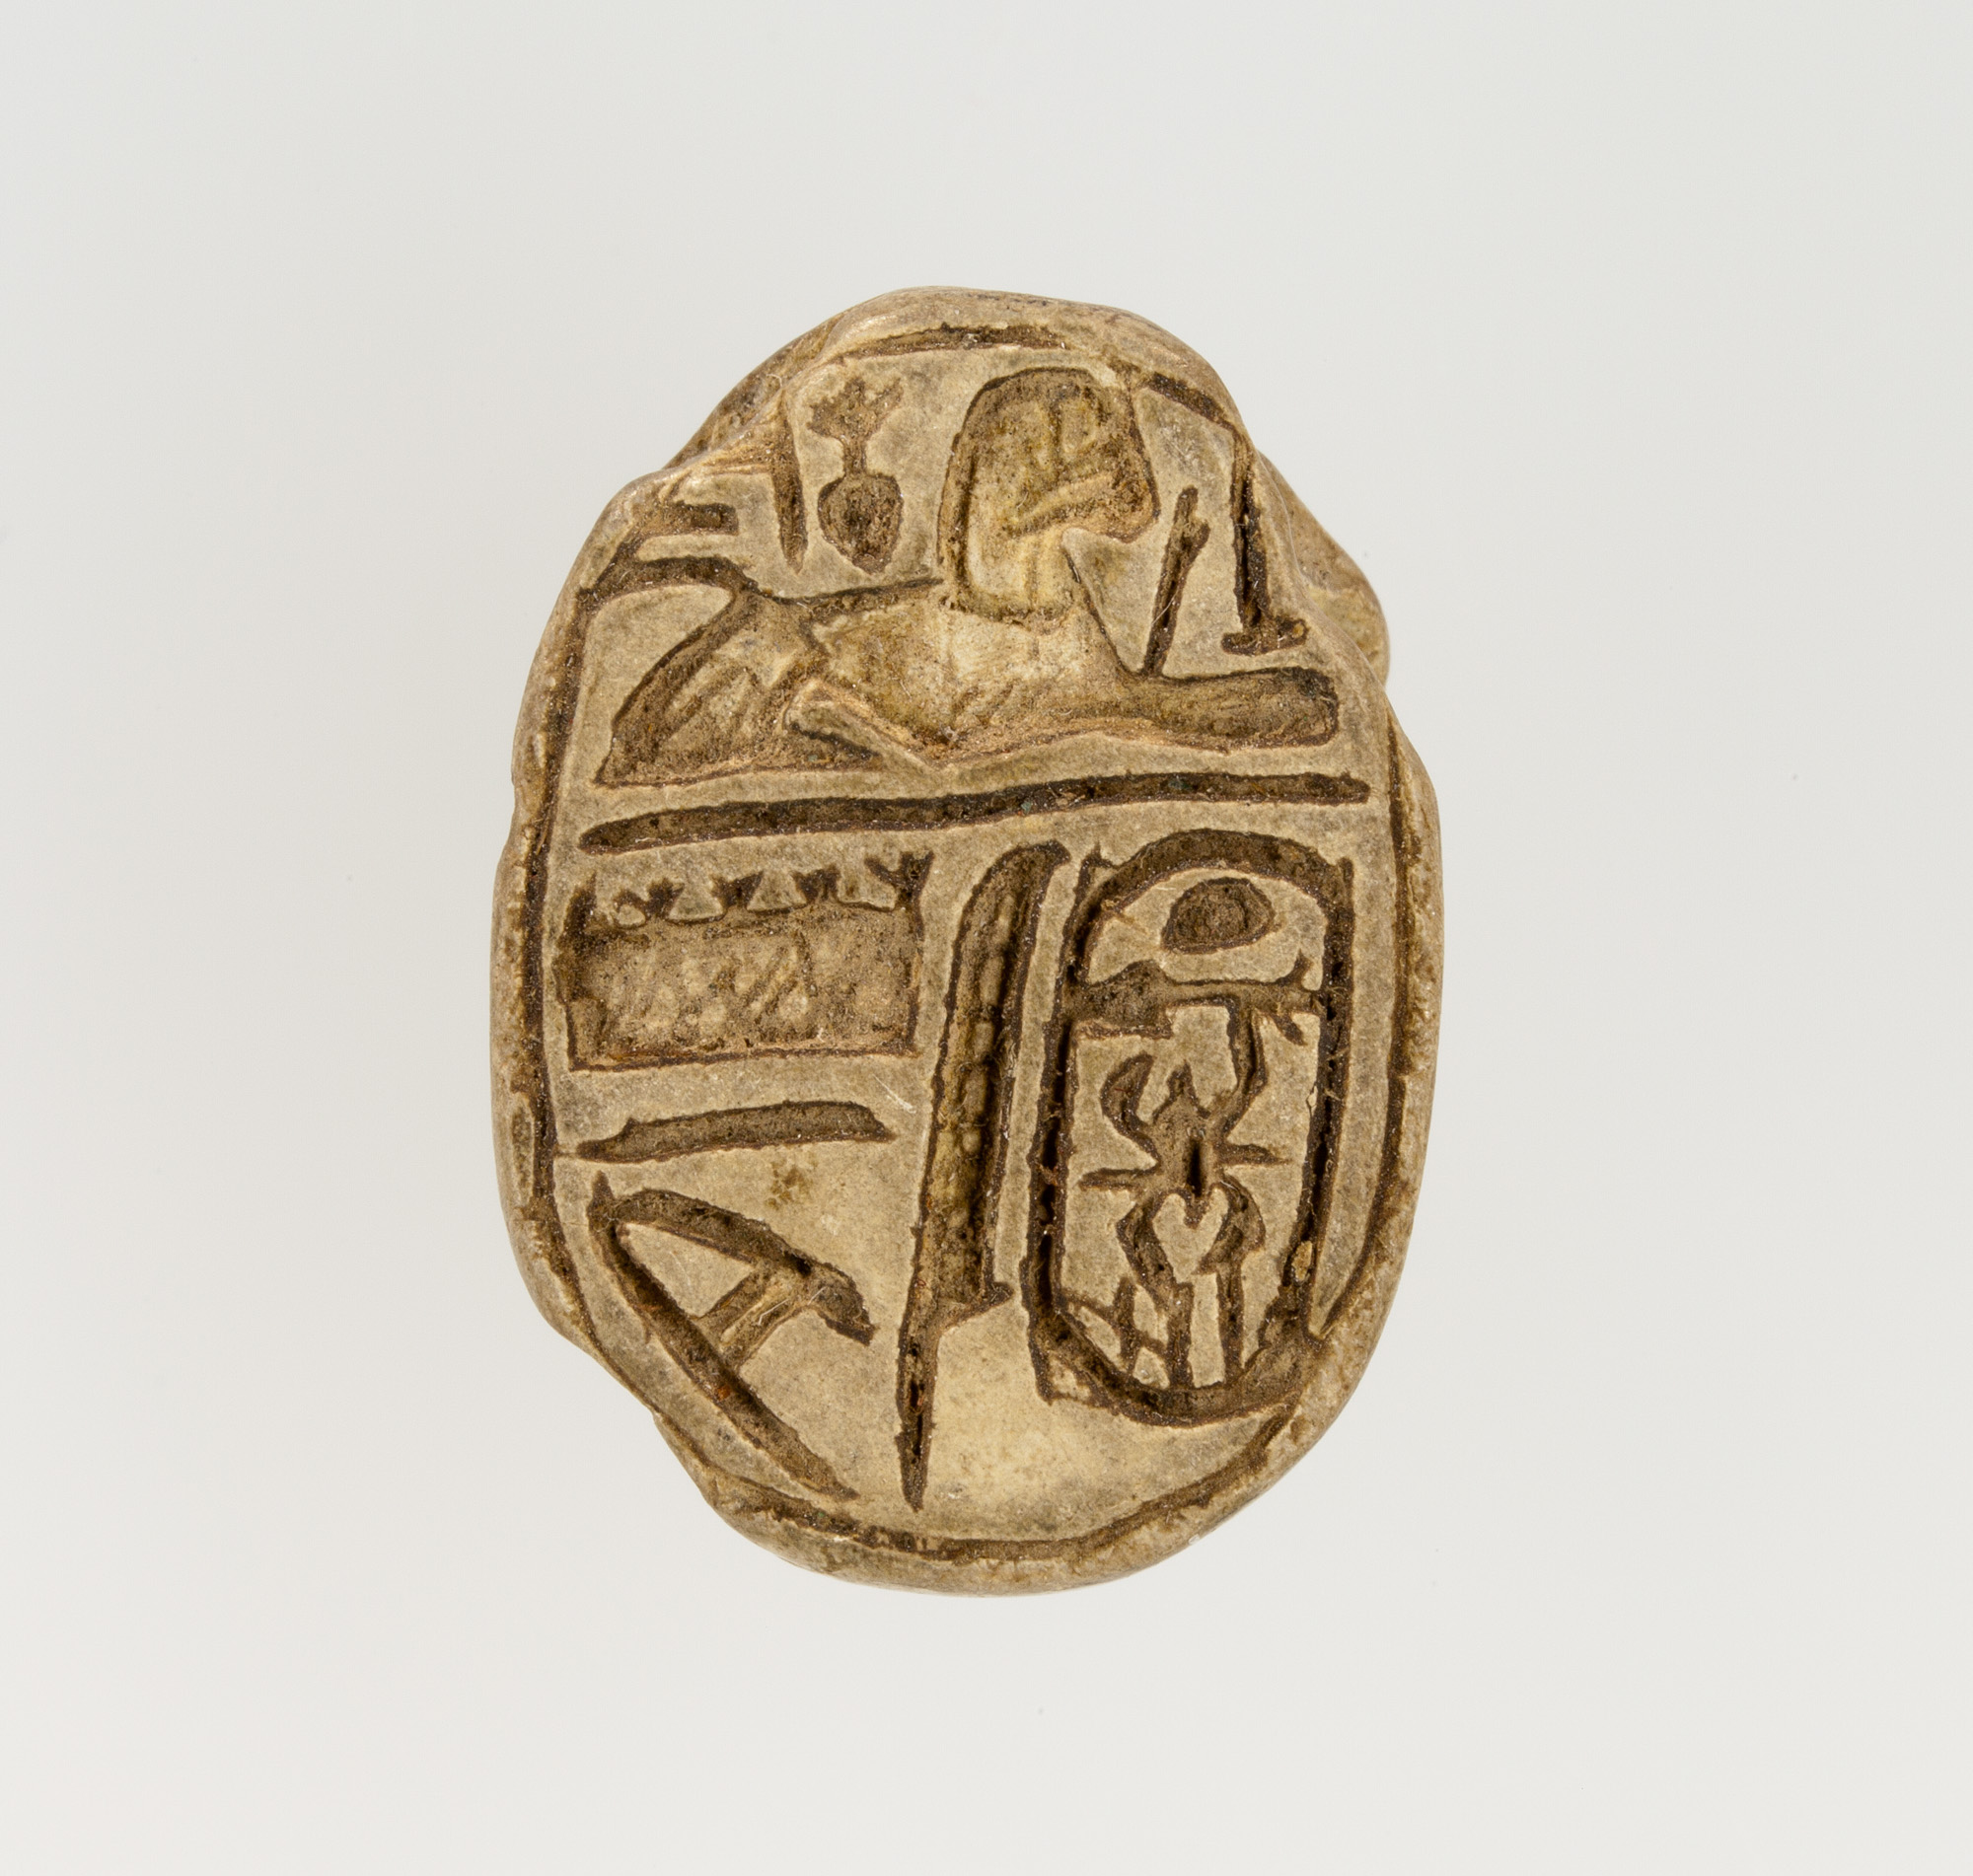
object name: scarab, amenhotep ii, aakheperure beloved of amun, lion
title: Scarab Inscribed with the Throne Name of Amenhotep II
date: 1427-1401 BCE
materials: stone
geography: egypt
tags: cartouches,hieroglyphs,scarabs